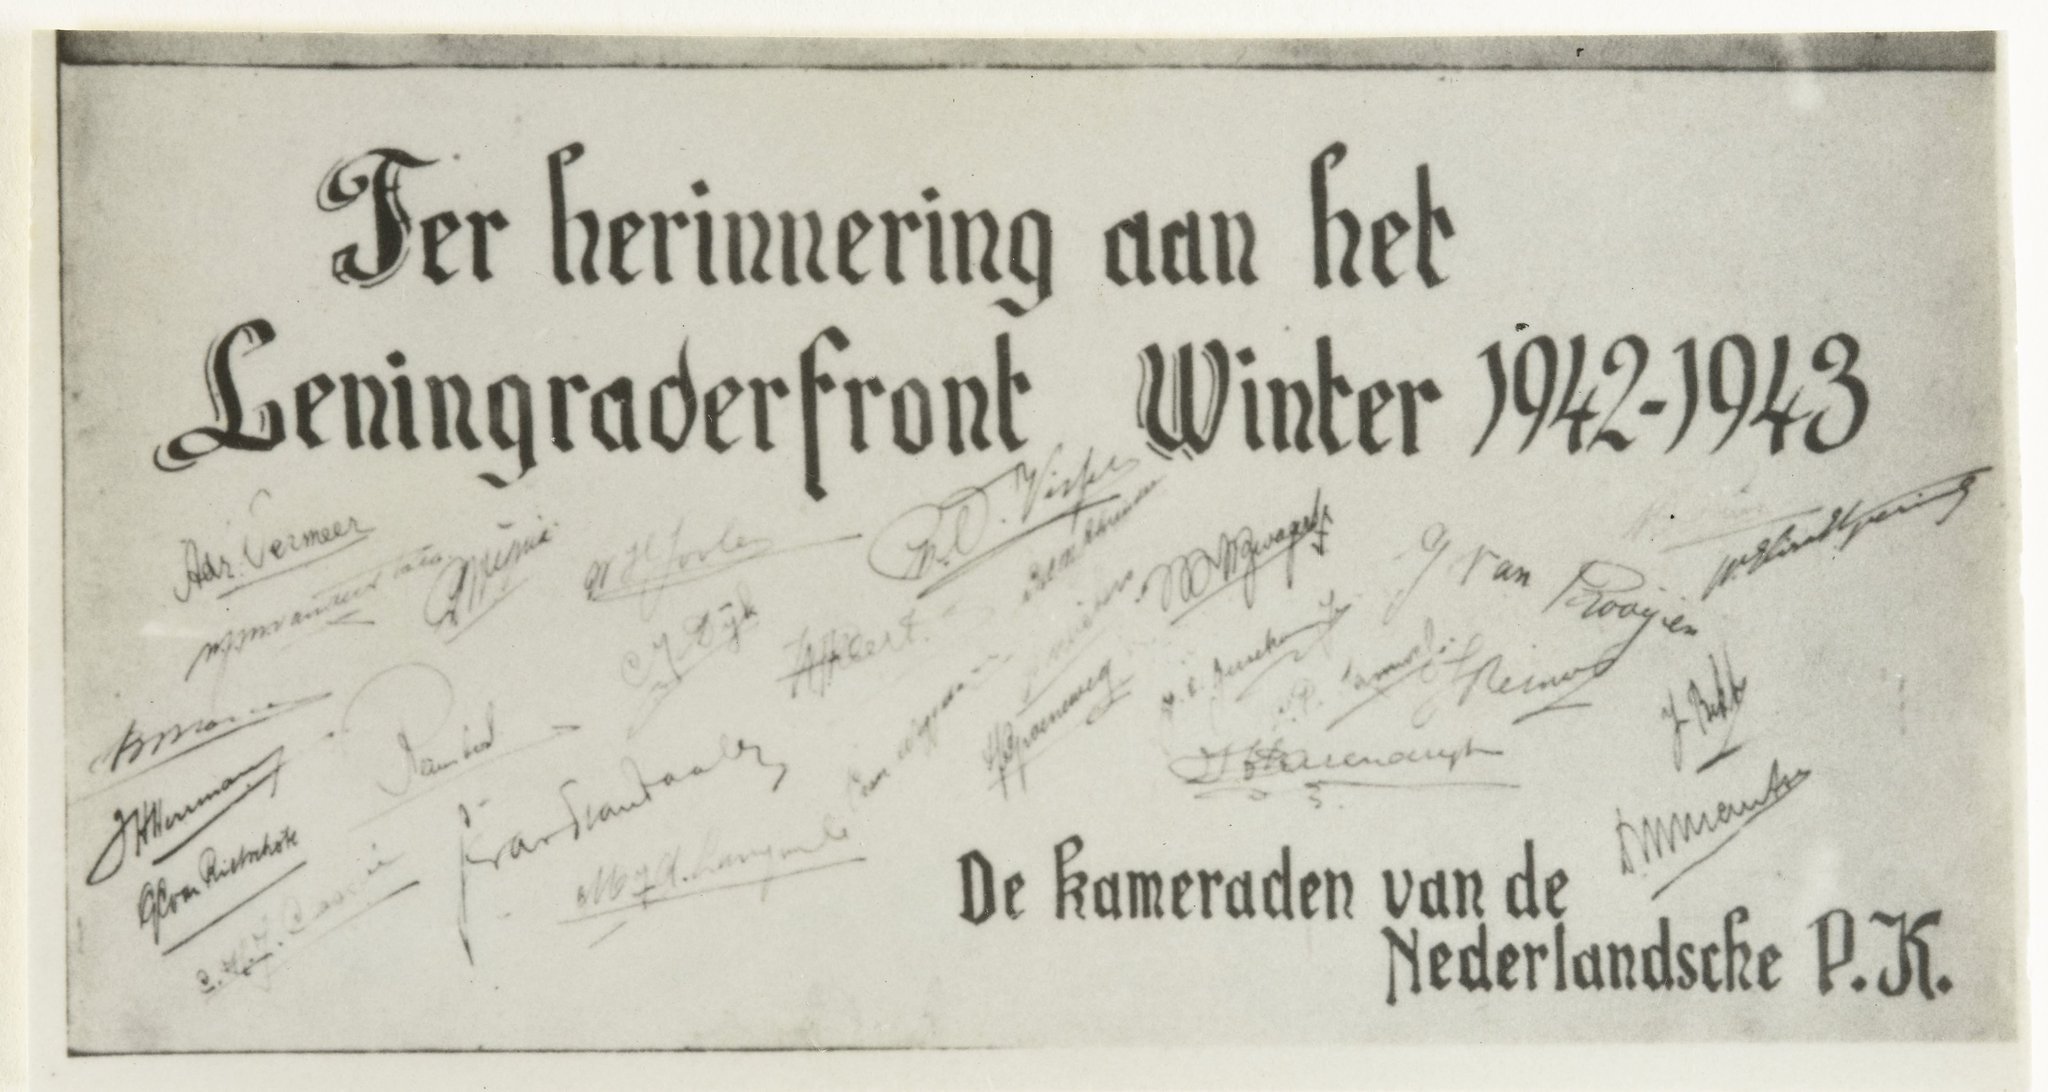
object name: contact print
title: Herinneringskaart aan het Oostfront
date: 1942-1944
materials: photographic support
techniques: photography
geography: netherlands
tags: political propaganda, netherlands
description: Een kaart ter herinnering aan de tijd aan het Oostfront bij Leningrad. Opschrift: "Ter herinnering aan het Leningraderfront. Winter 1942 - 1943. De kameraden van de Nederlandsche PK" (Propaganda Kompagnie). De kaart staat verder vol met handtekeningen.